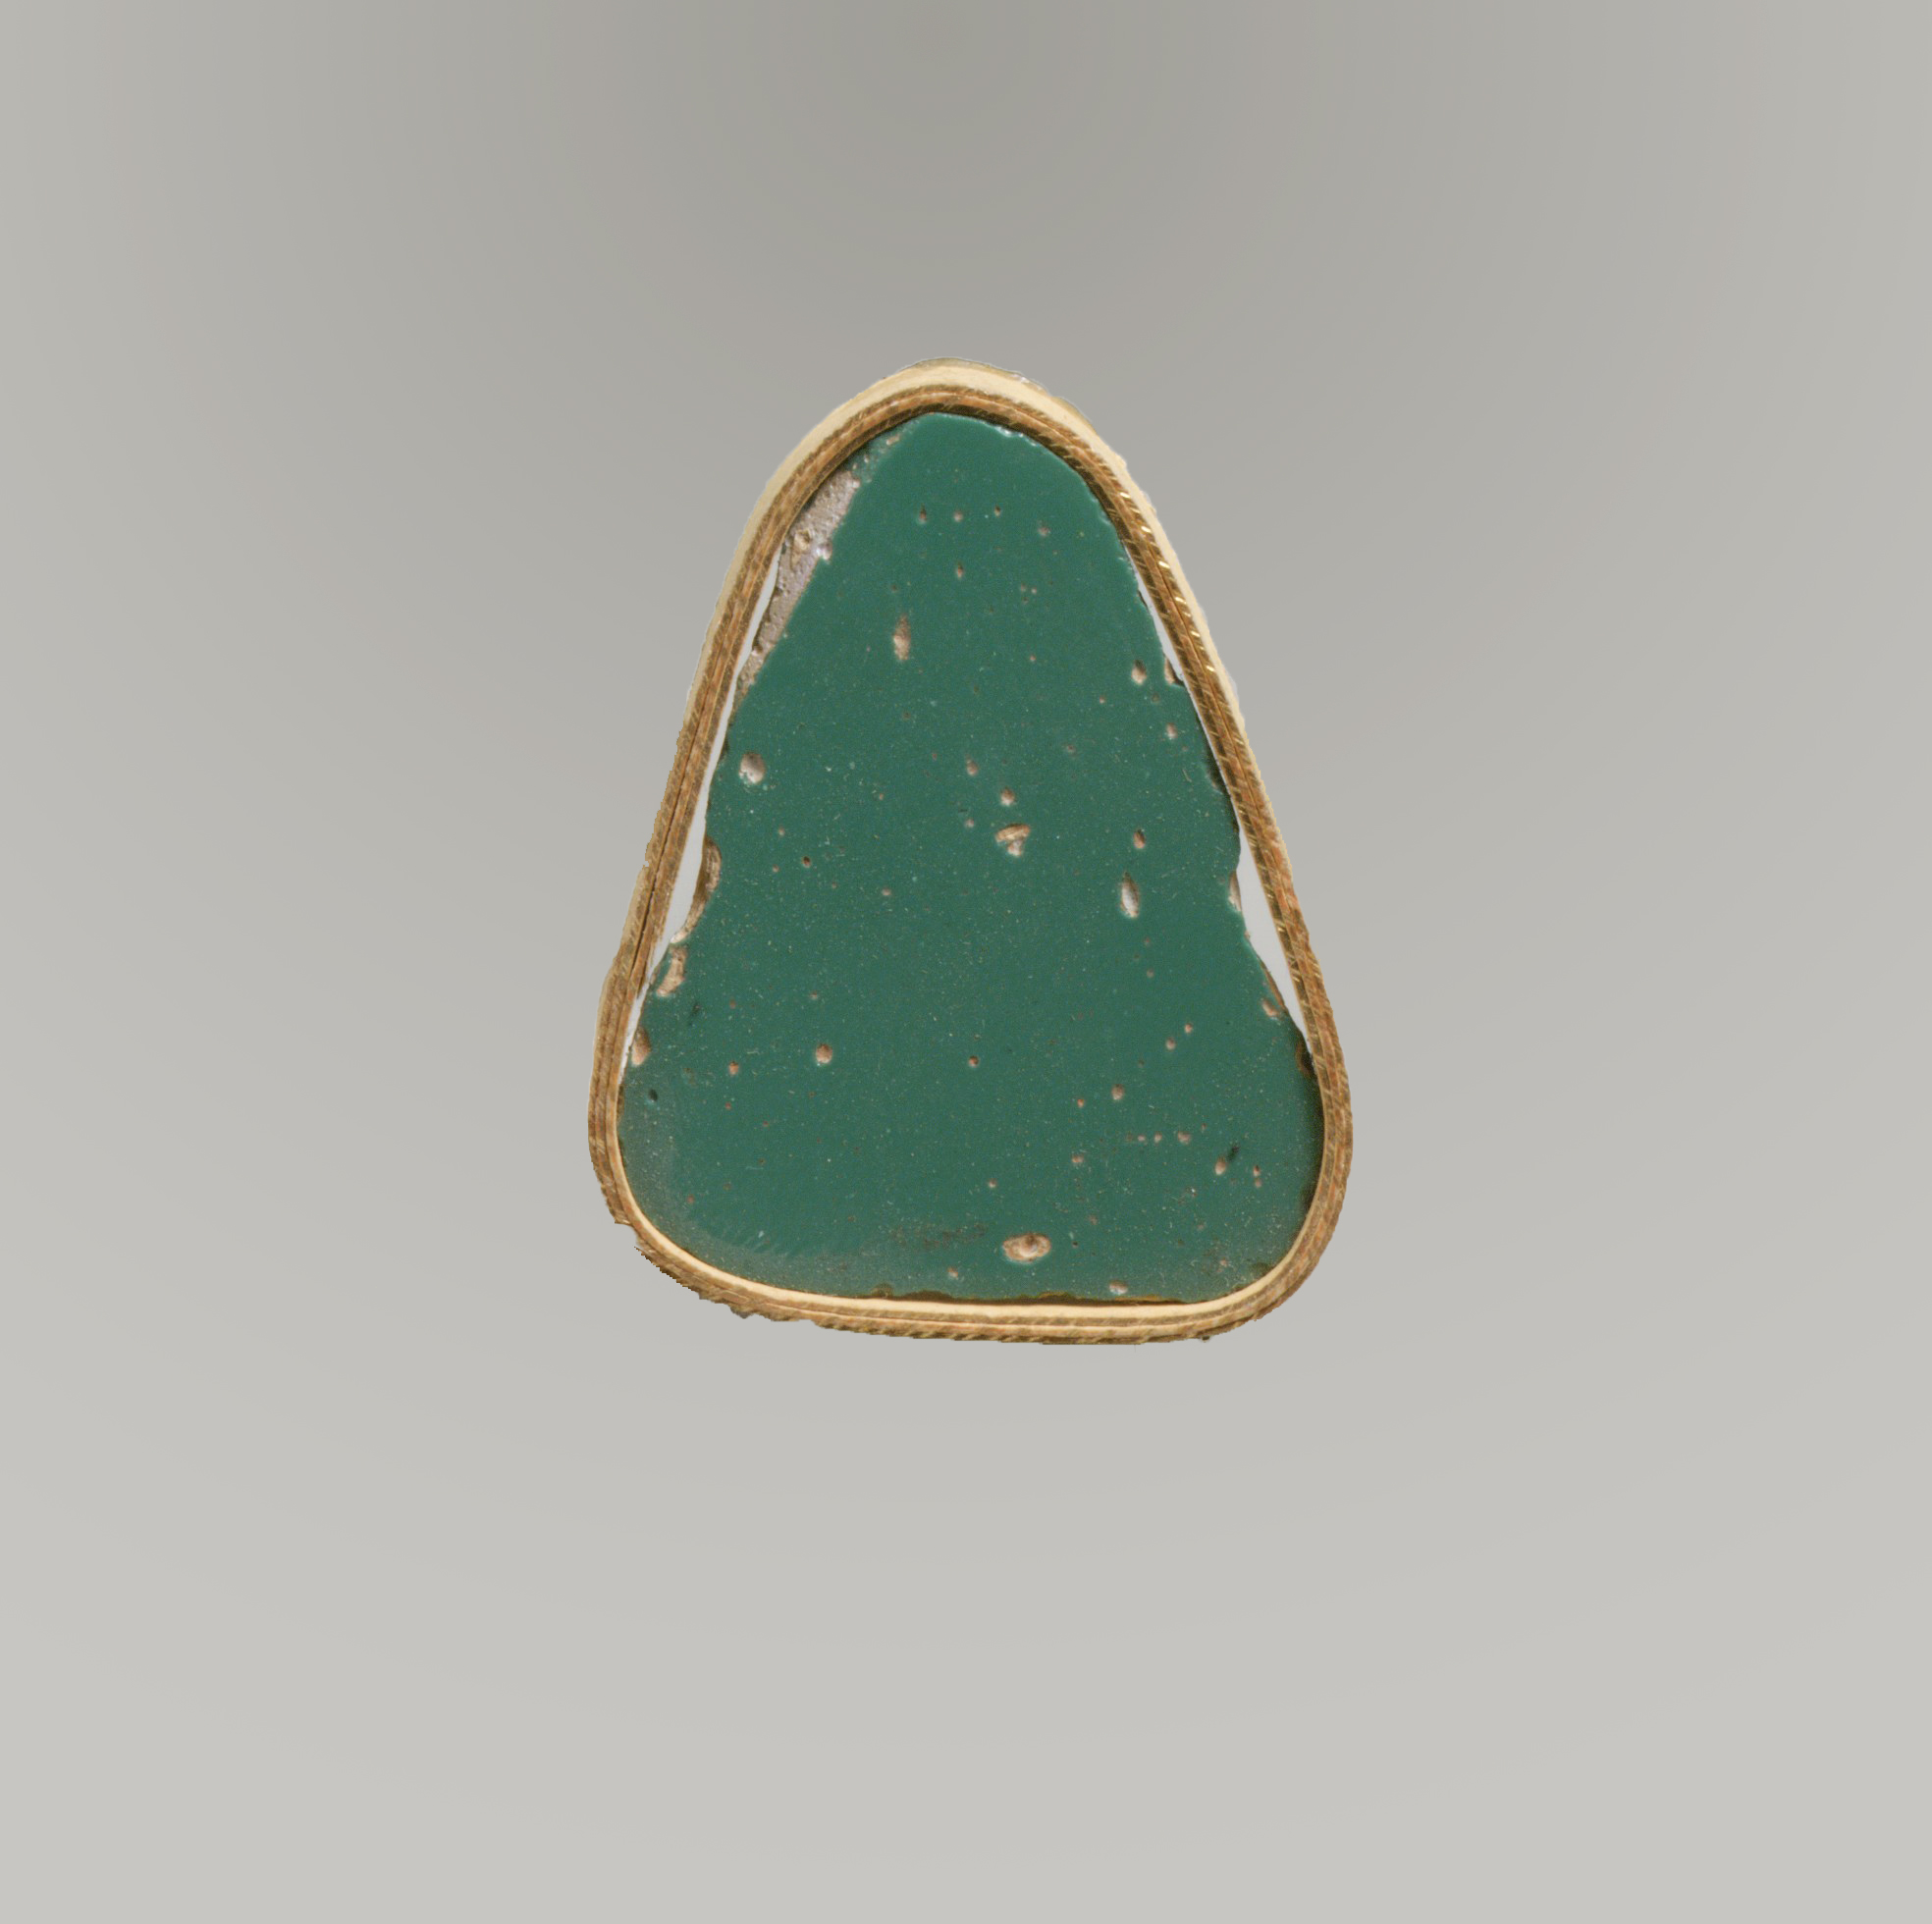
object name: fragment, monochrome inlay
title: Glass monochrome inlay fragment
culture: roman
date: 1-50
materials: glass